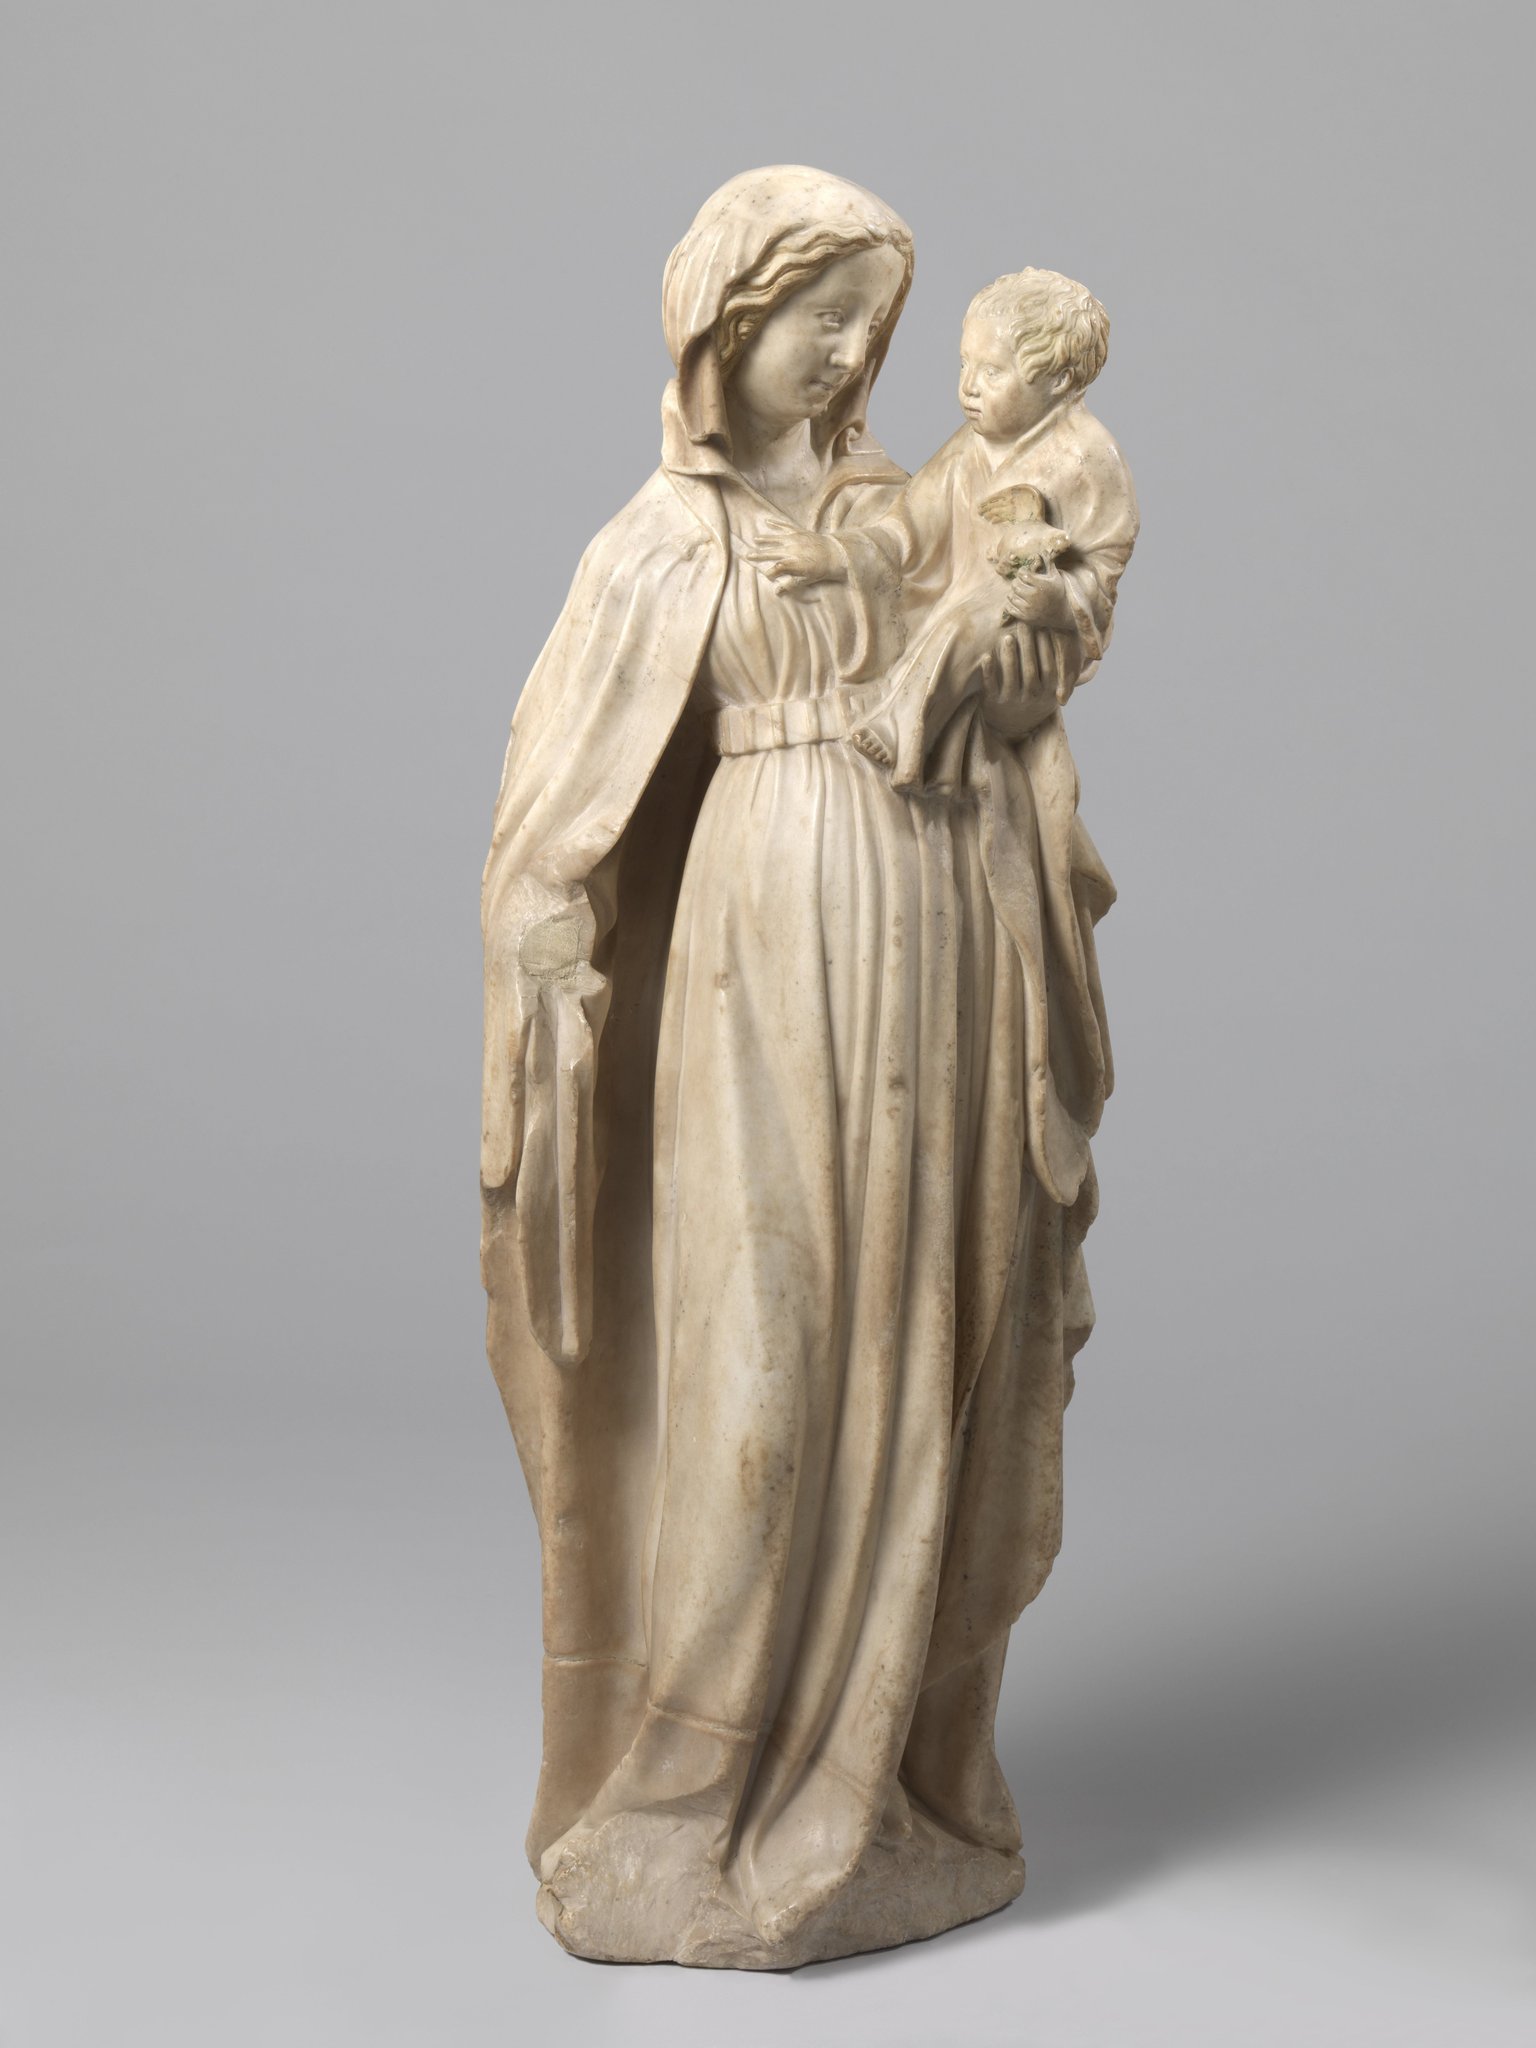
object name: figure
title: Virgin and Child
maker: Anonymous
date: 1400-1424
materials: alabaster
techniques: gilding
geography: ile-de-france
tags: mary standing (or half-length), the christ-child sitting on her arm (christ-child to mary's left)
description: The clothes of this elegant Virgin reflect French courtly fashions of around 1400. Fashionably dressed and not wearing a crown, she resembles a young noblewoman. There are few other statues of the Virgin from this period with such an aristocratic air. For this reason it is thought that this one was probably made for someone close to the French court.